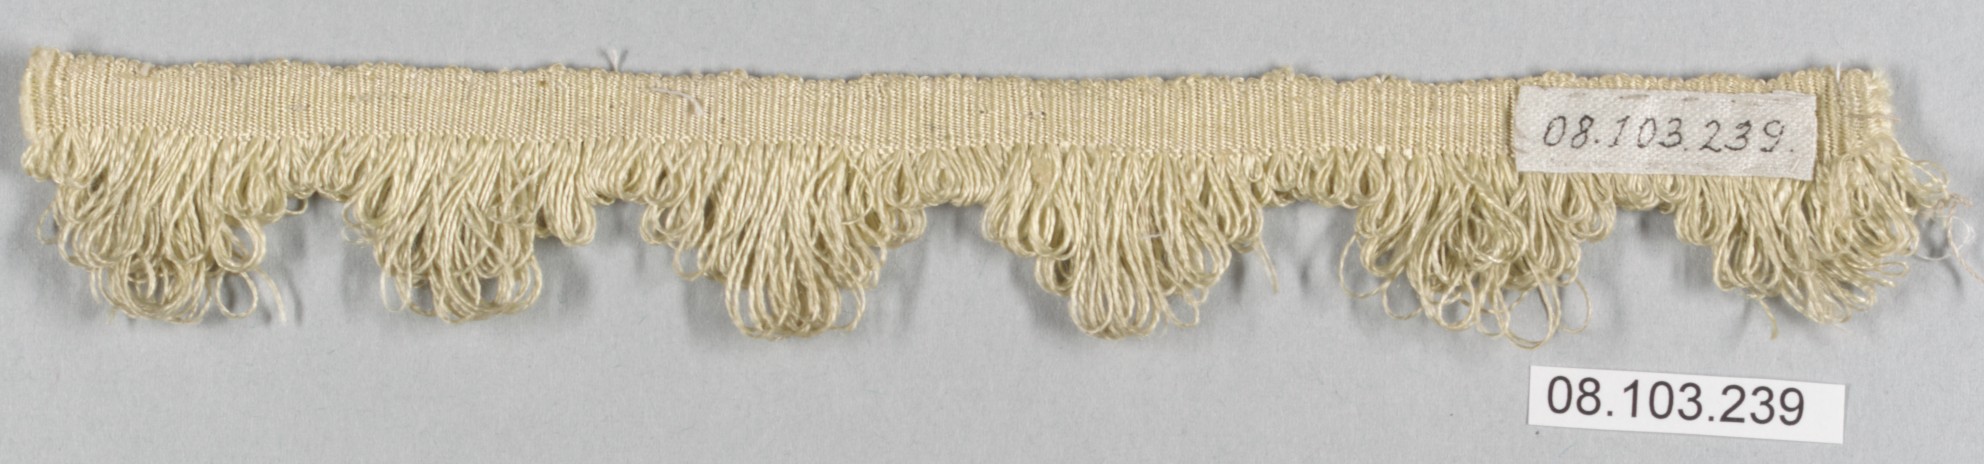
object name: gimp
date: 1801-1900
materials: silk